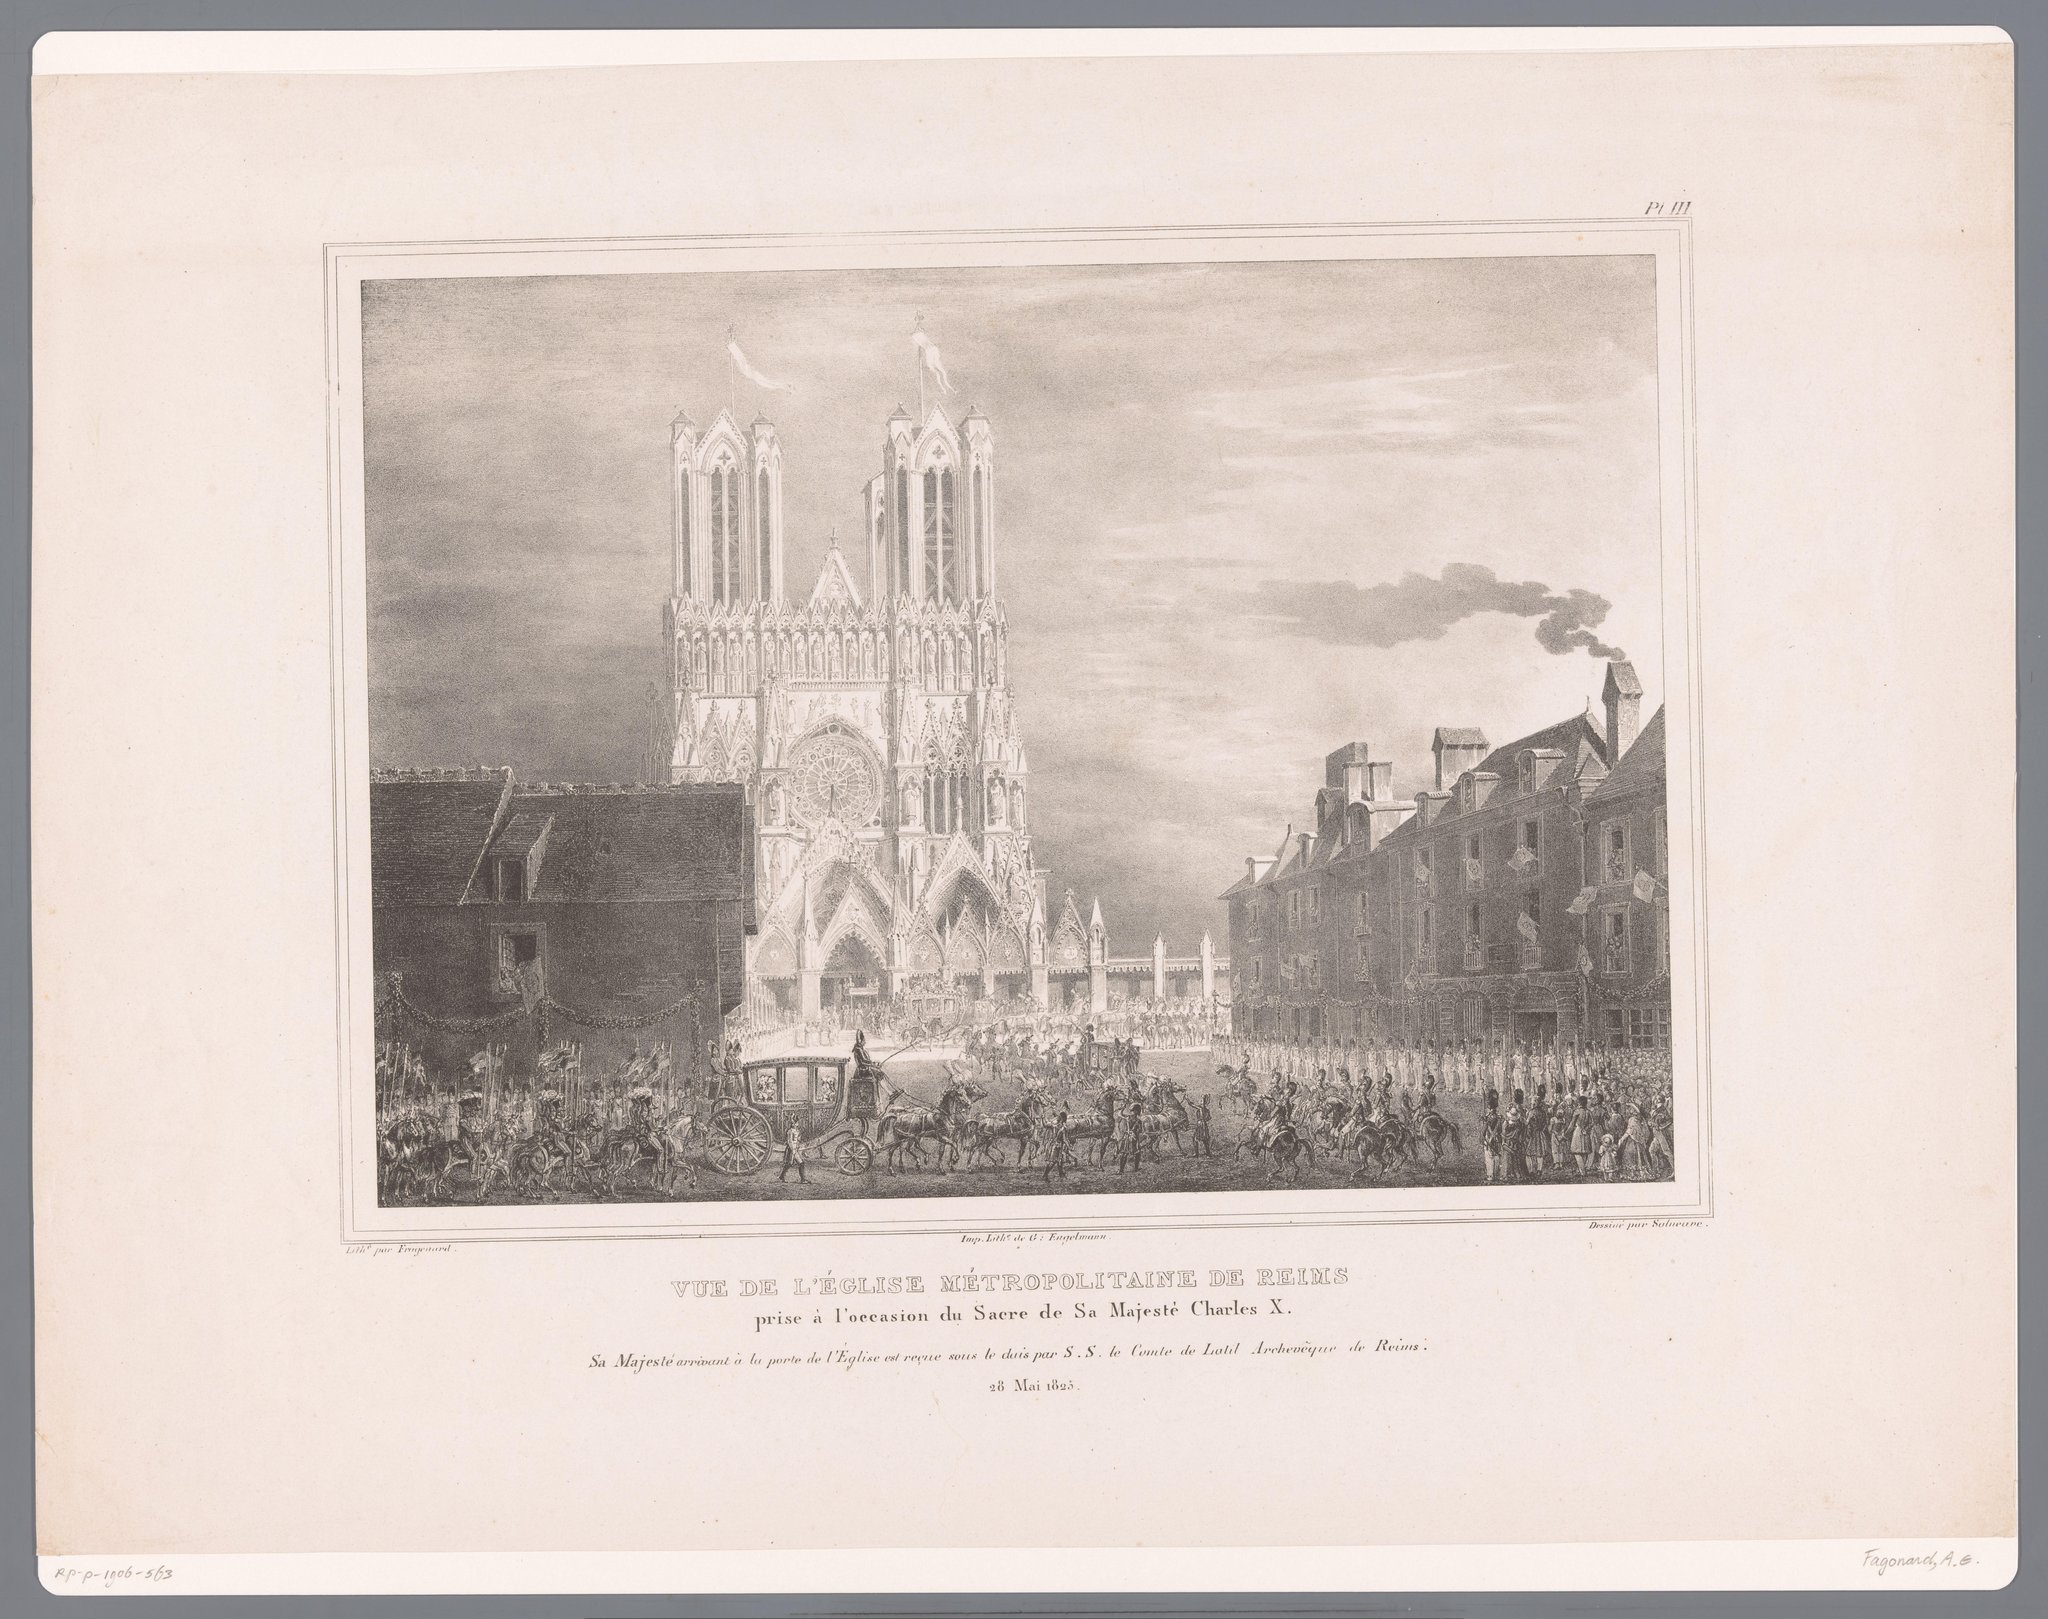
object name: print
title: Zicht op de kathedraal van Reims op de kroningsdag van Karel X van Frankrijk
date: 1825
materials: paper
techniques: lithograph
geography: paris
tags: coronation procession, four-wheeled, animal-drawn vehicle, e.g.: cab, carriage, coach, historical persons, church (exterior)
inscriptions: collector's mark: Lugt 2228a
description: Karel X arriveert per koets bij de ingang van de kathedraal en wordt daar opgewacht door Jean-Baptiste de Latil, aartsbisschop van Reims.